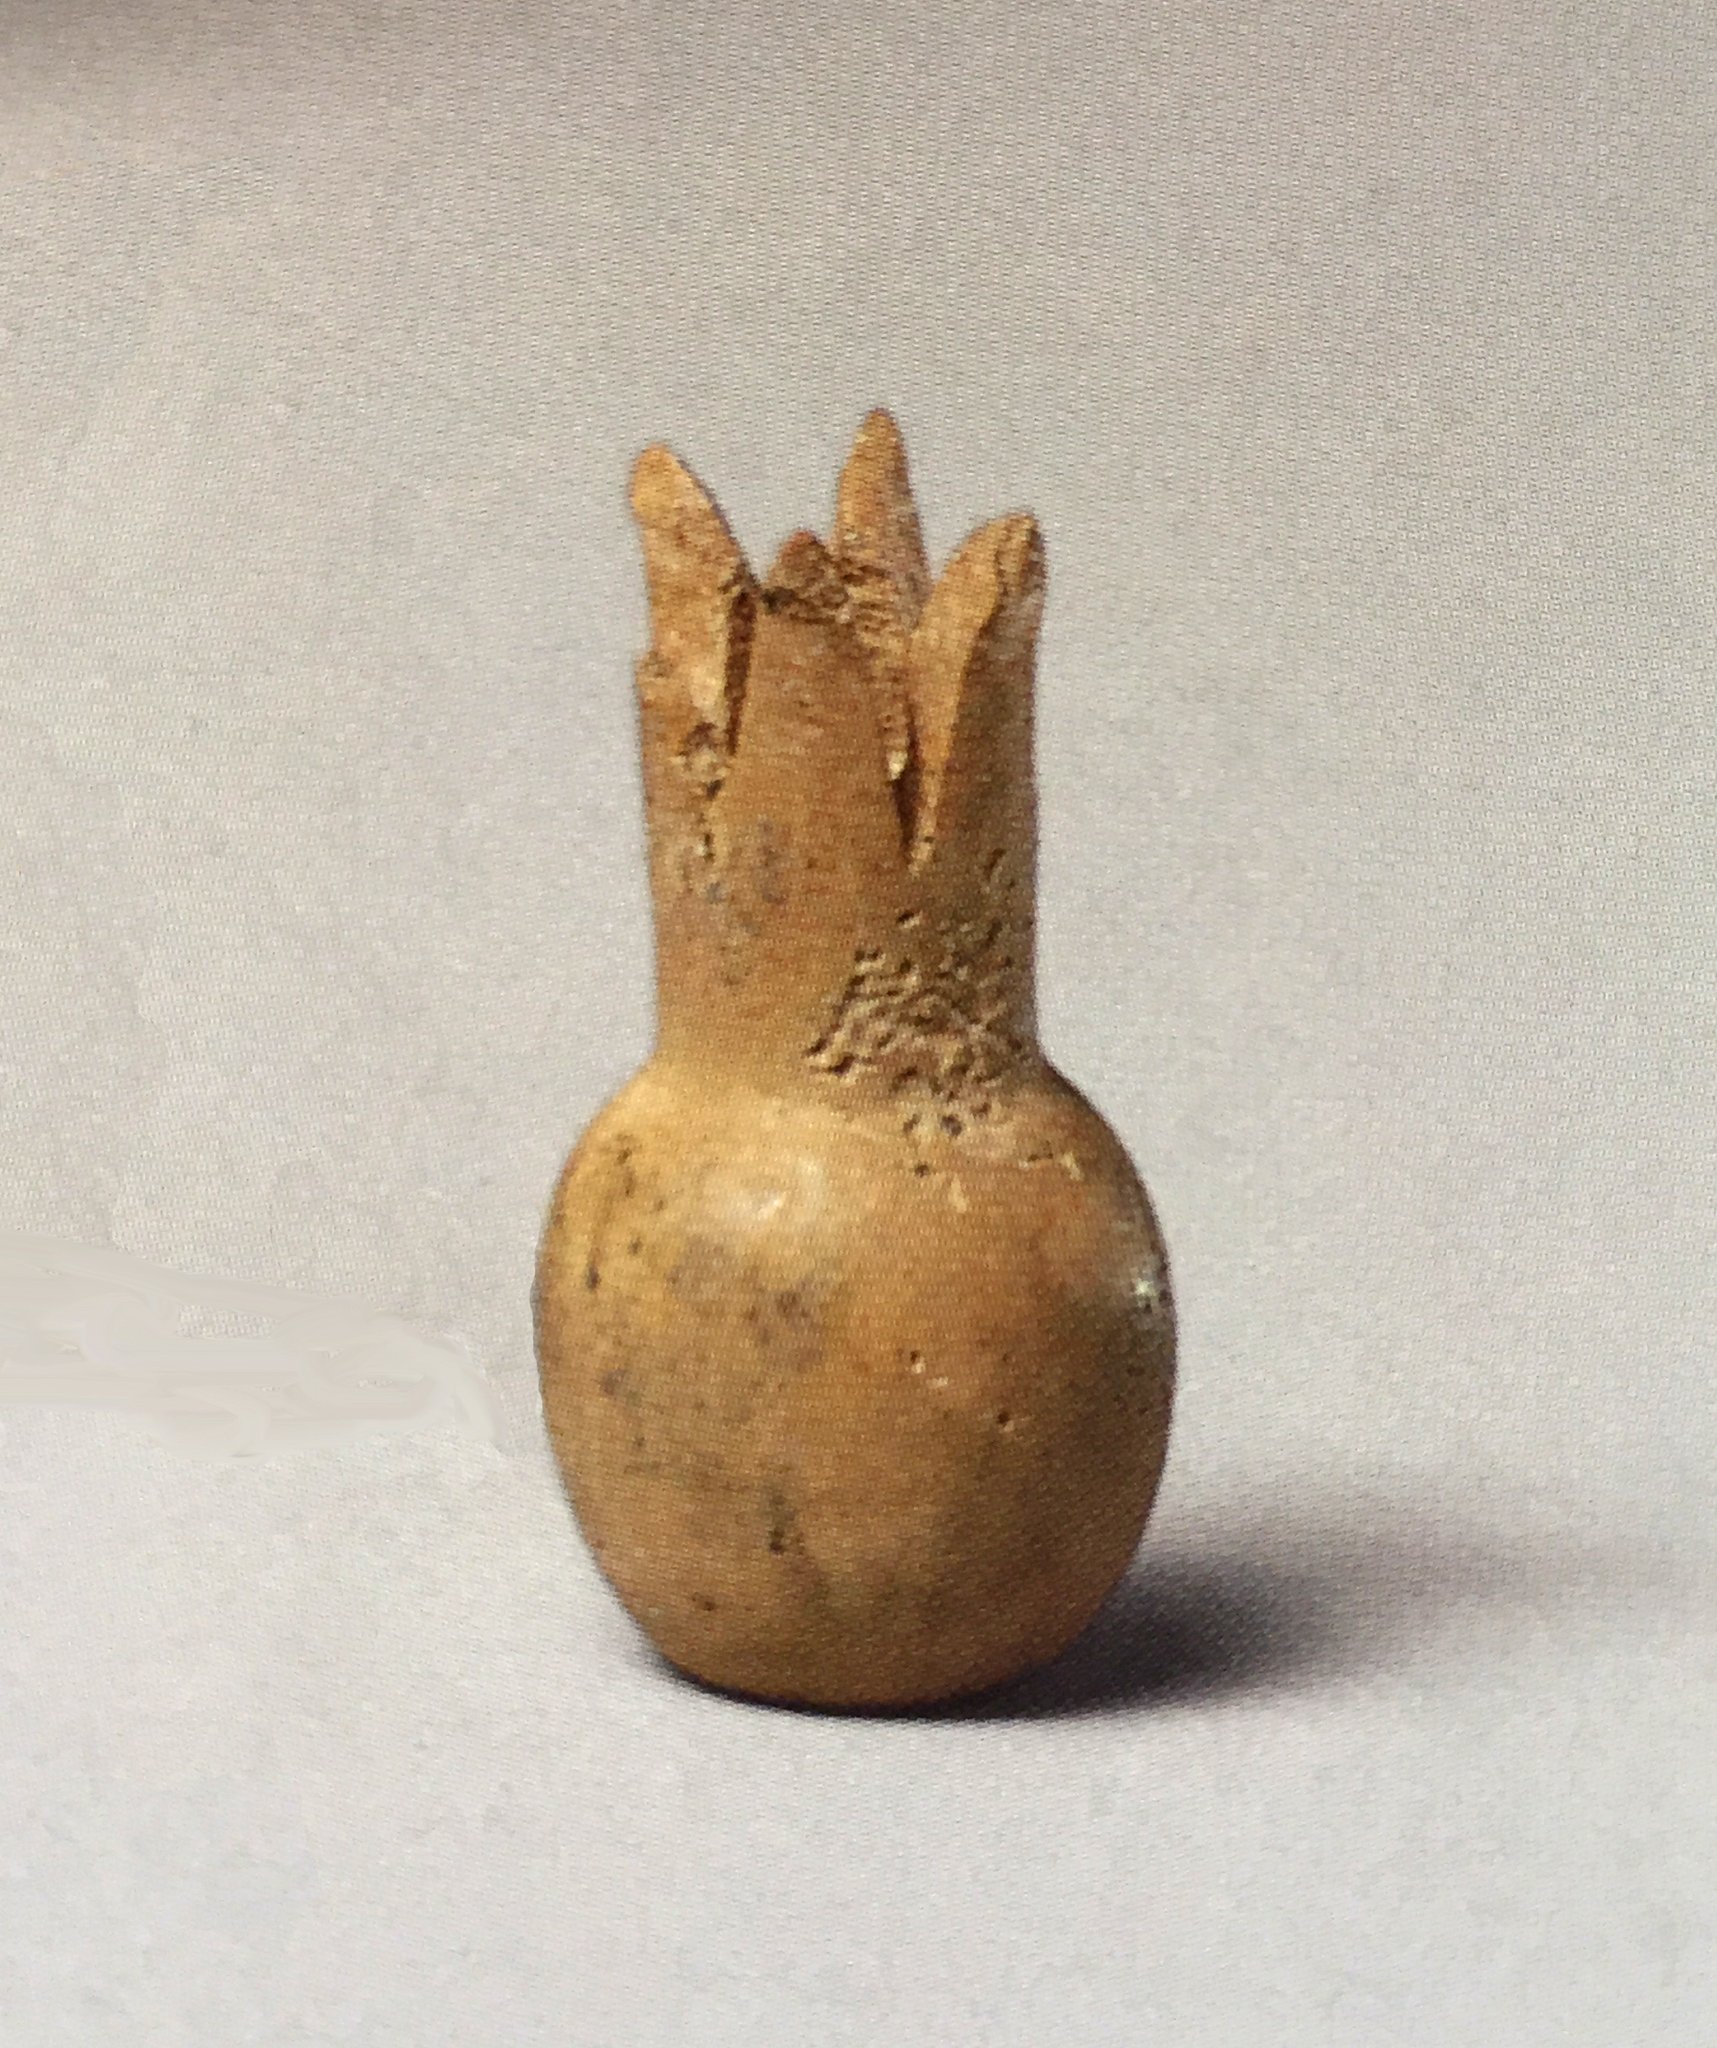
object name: pinhead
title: Ivory pomegranate-shaped finial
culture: cypriot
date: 1300-1101 BCE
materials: ivory